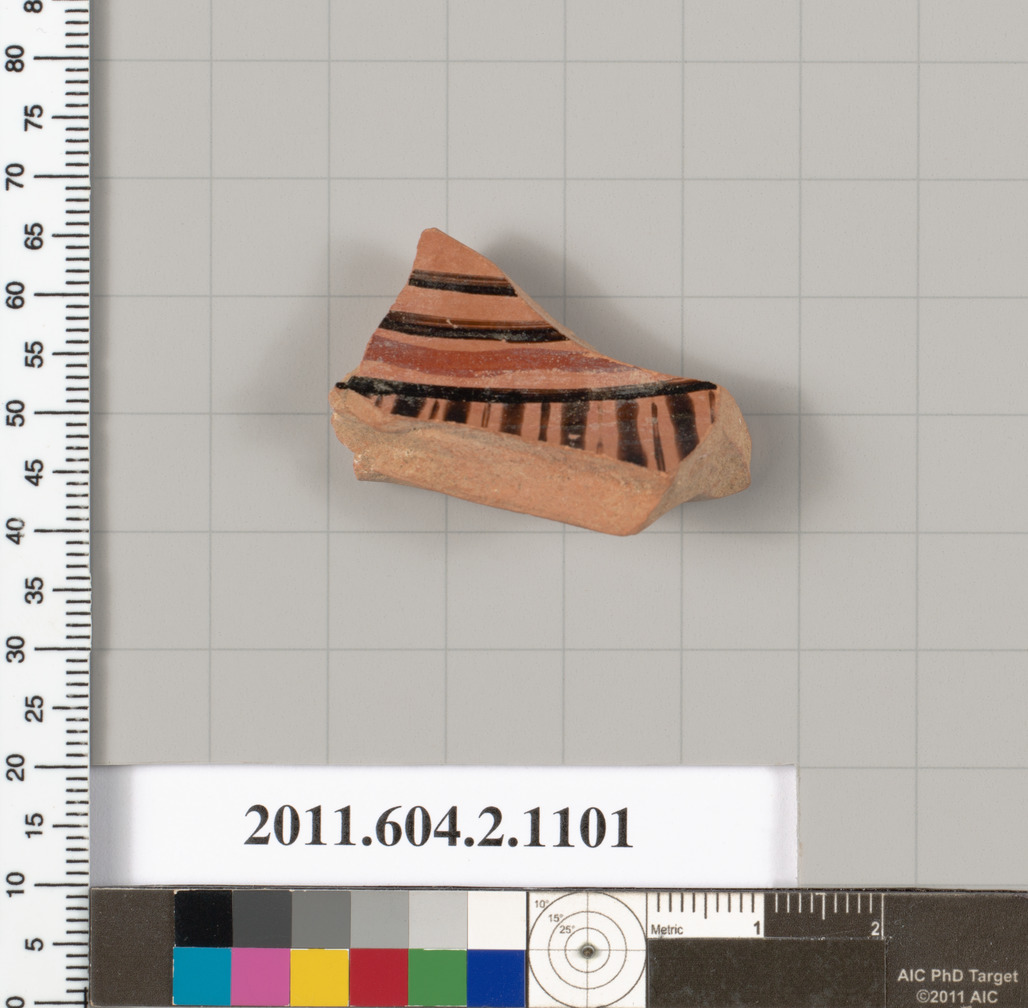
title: Terracotta fragment from an undetermined shape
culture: greek, attic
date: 534-468 BCE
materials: terracotta